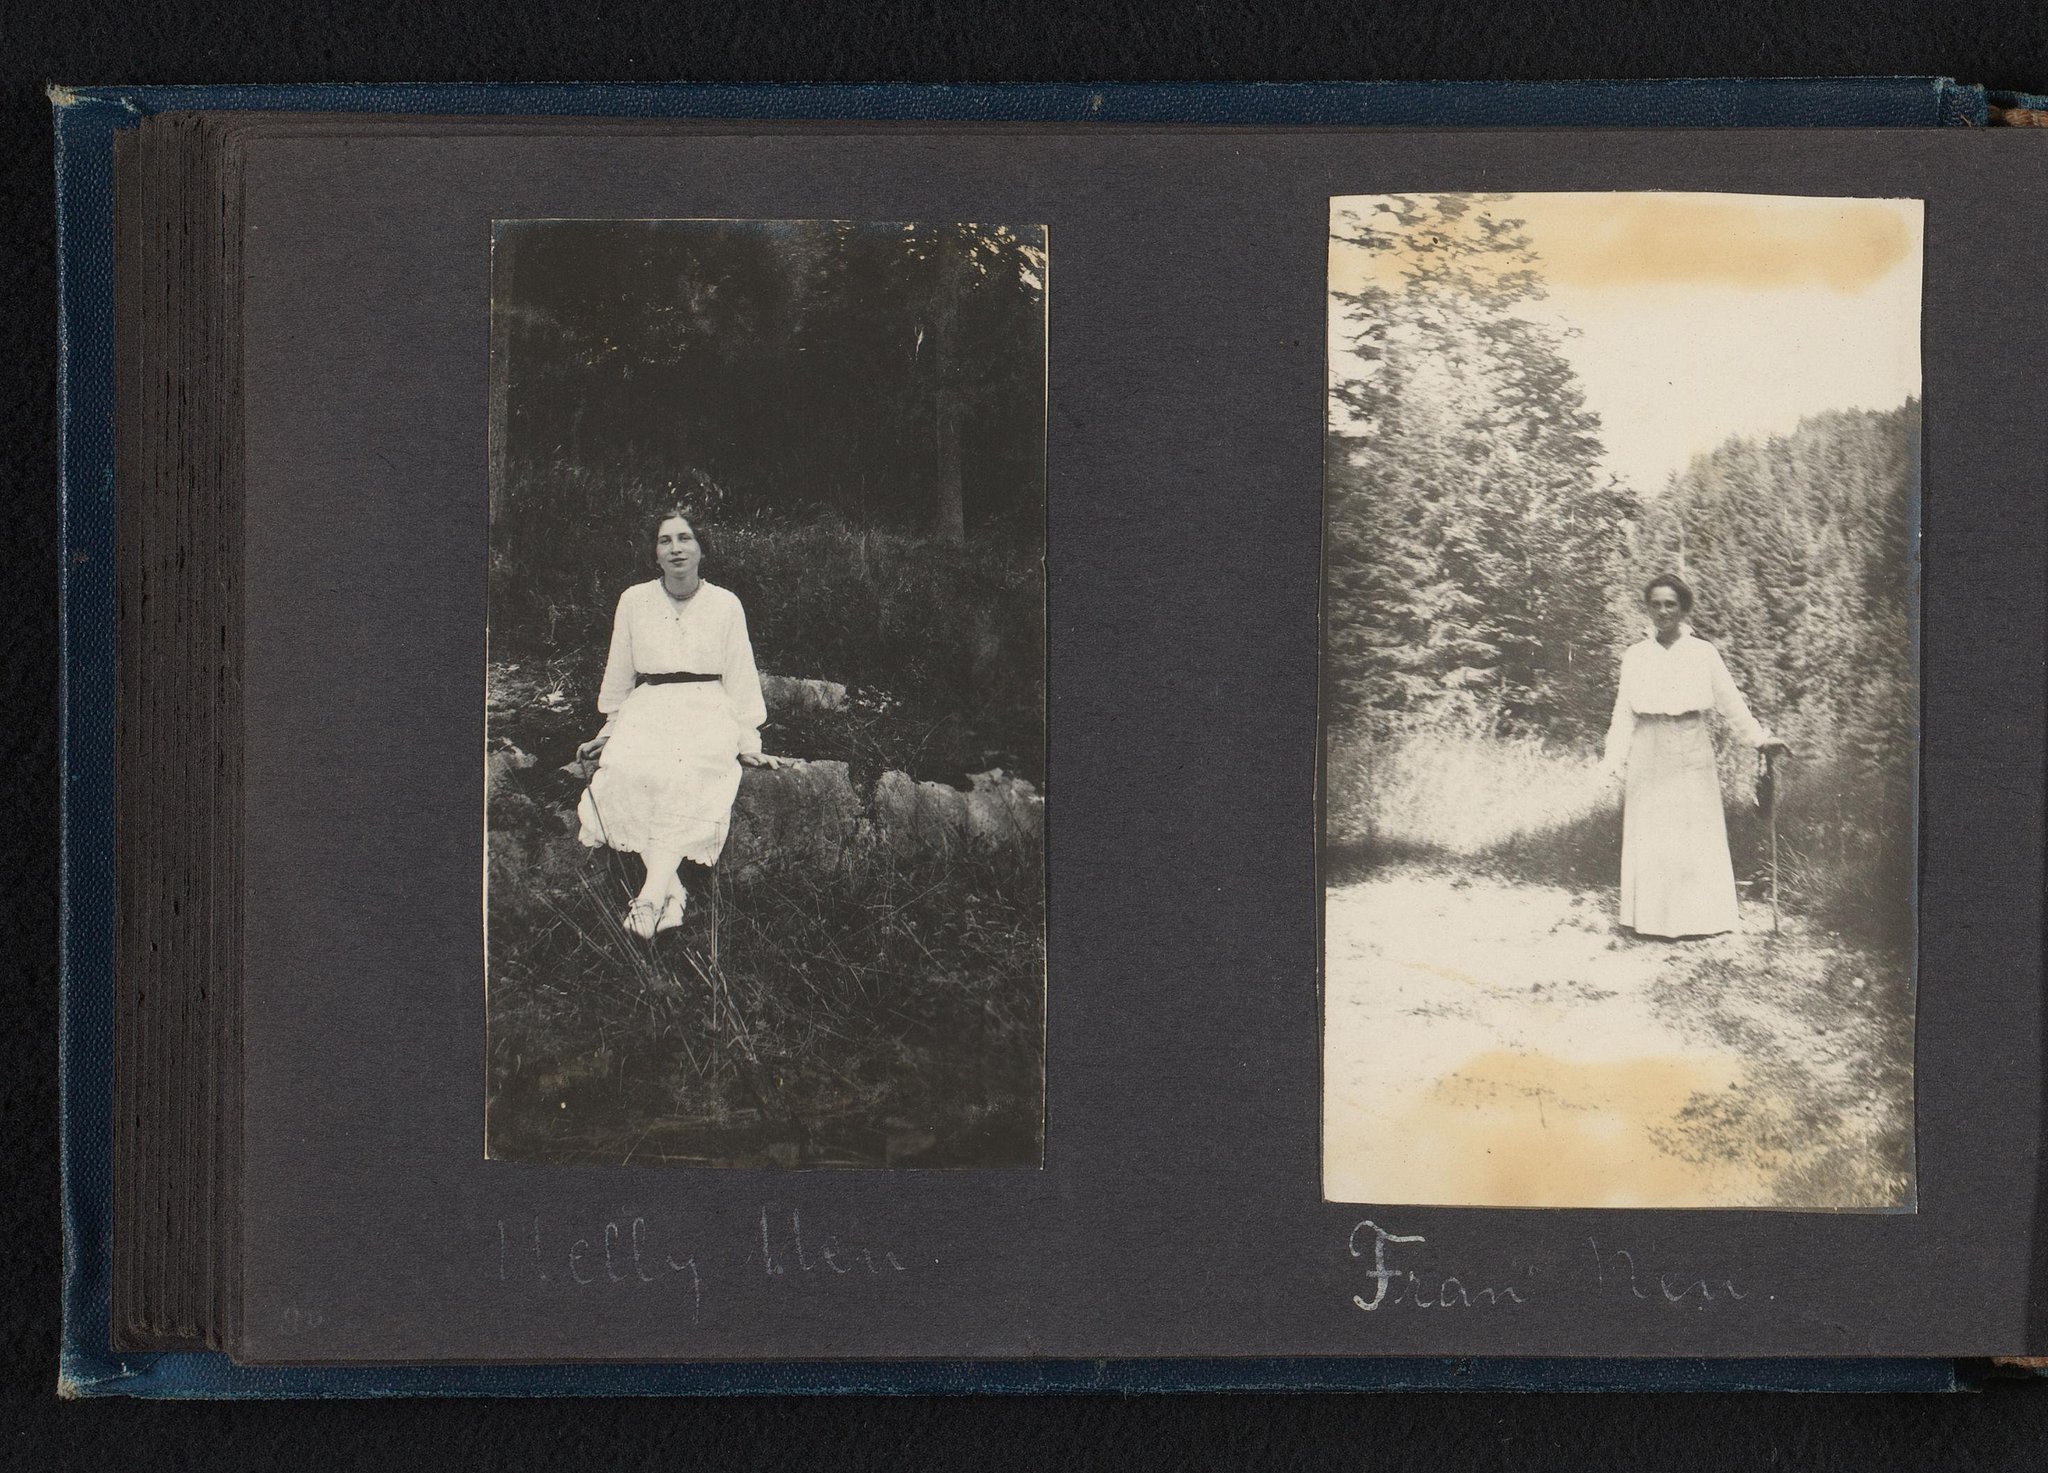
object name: album leaf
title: Vriendinnen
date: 1916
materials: paper, photographic support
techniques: gelatin silver print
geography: germany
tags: else wachenheimer-moos, walking, hiking (recreation), historical persons - bb - woman, germany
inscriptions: inscription: ‘Nelly Neu / Frau Neu’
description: Albumblad met twee foto's van vriendinnen. Onderdeel van het fotoalbum van Else Wachenheimer-Moos en haar broers Arthur en Willy Moos en anderen in de periode 1913-1918.